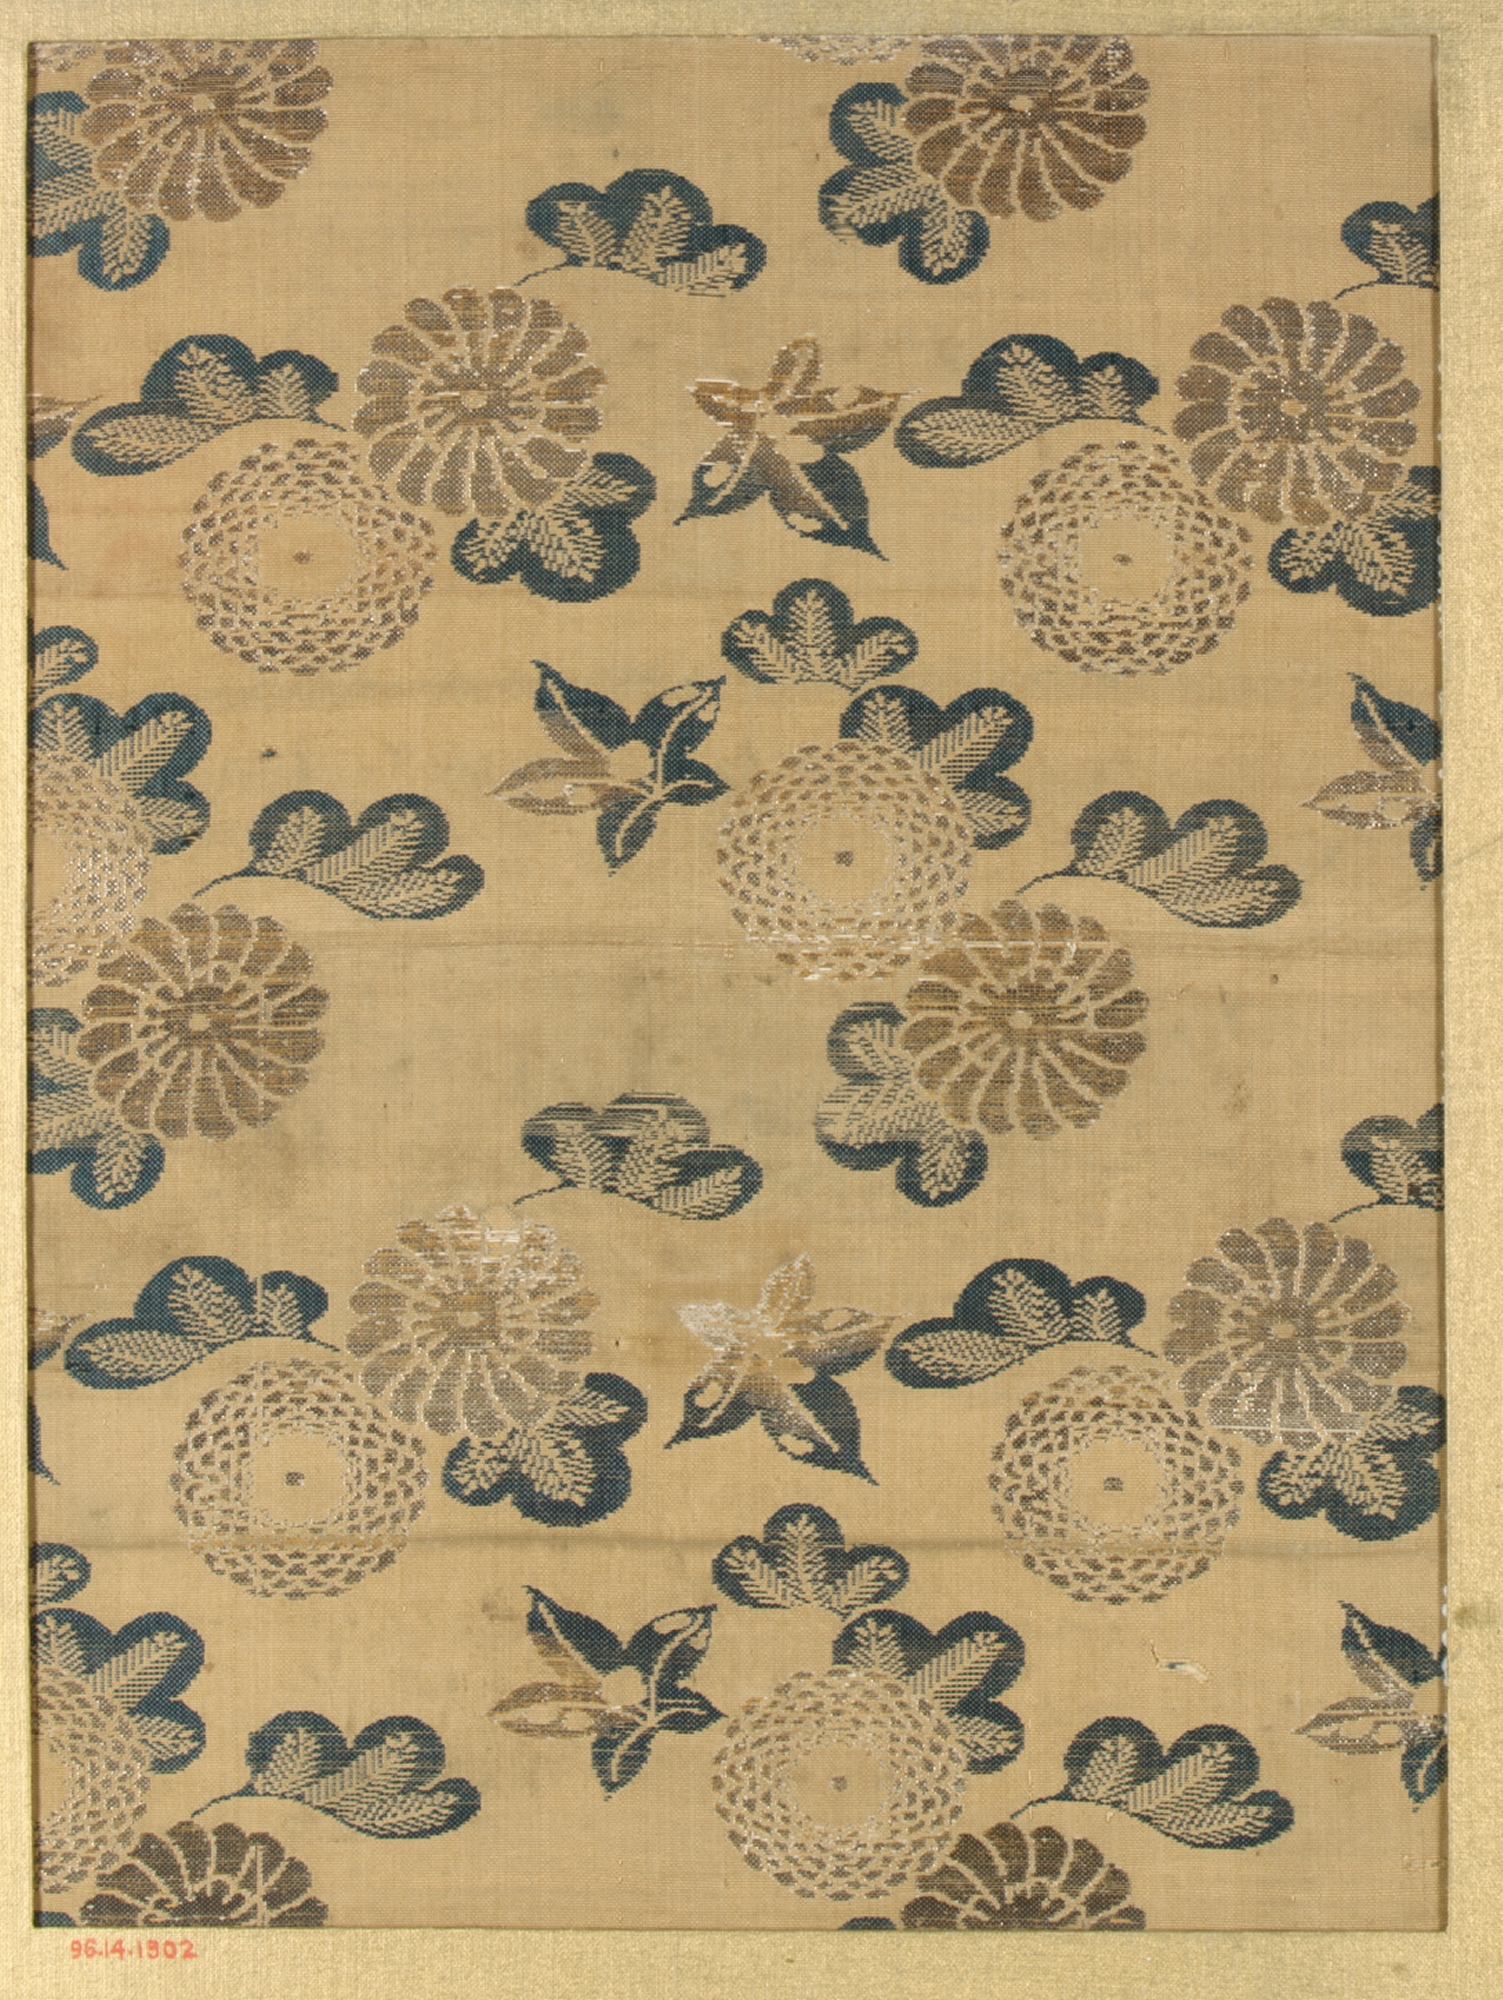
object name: piece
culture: japanese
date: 1701-1900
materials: silk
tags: flowers